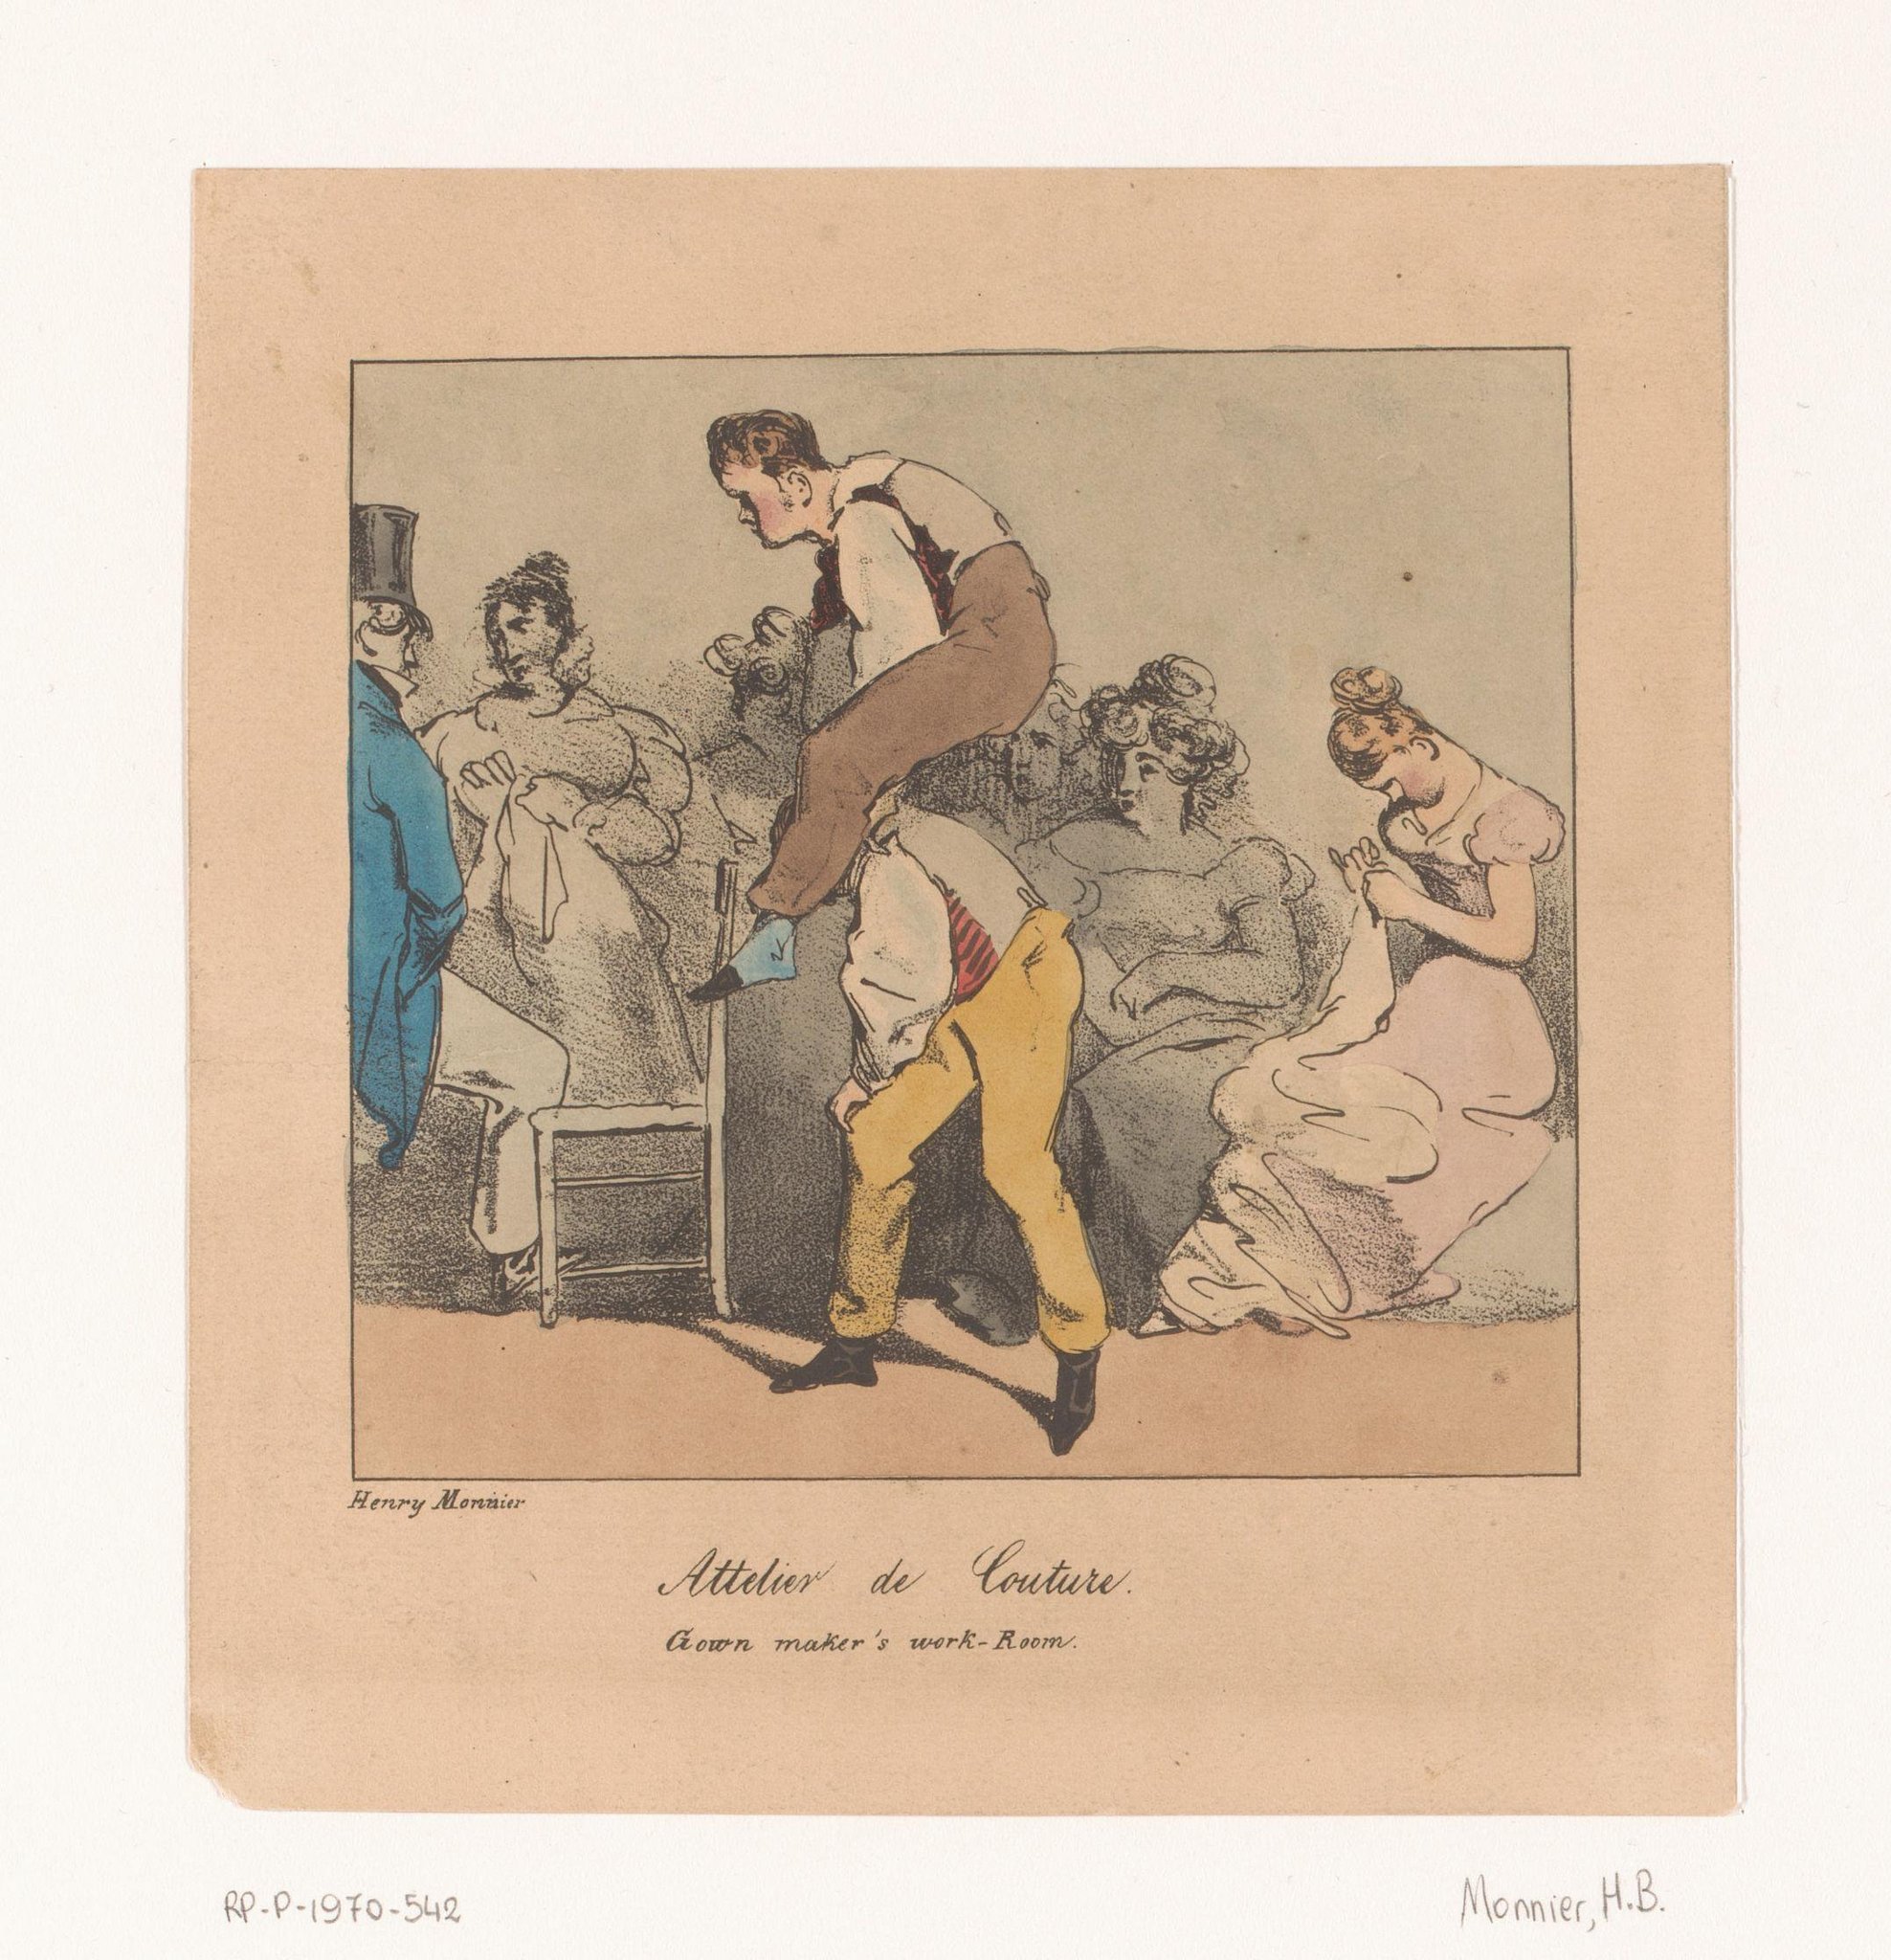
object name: print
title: Attelier de couture / Gown maker's work-room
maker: henry bonaventure monnier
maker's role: draughtsman, print maker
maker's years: 1799-1877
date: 1830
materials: paper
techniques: hand coloring, lithograph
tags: leap-frog and variants, tailor, dressmaker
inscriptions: collector's mark: Lugt 2228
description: Prent maakt deel uit van een serie van veertig prenten.